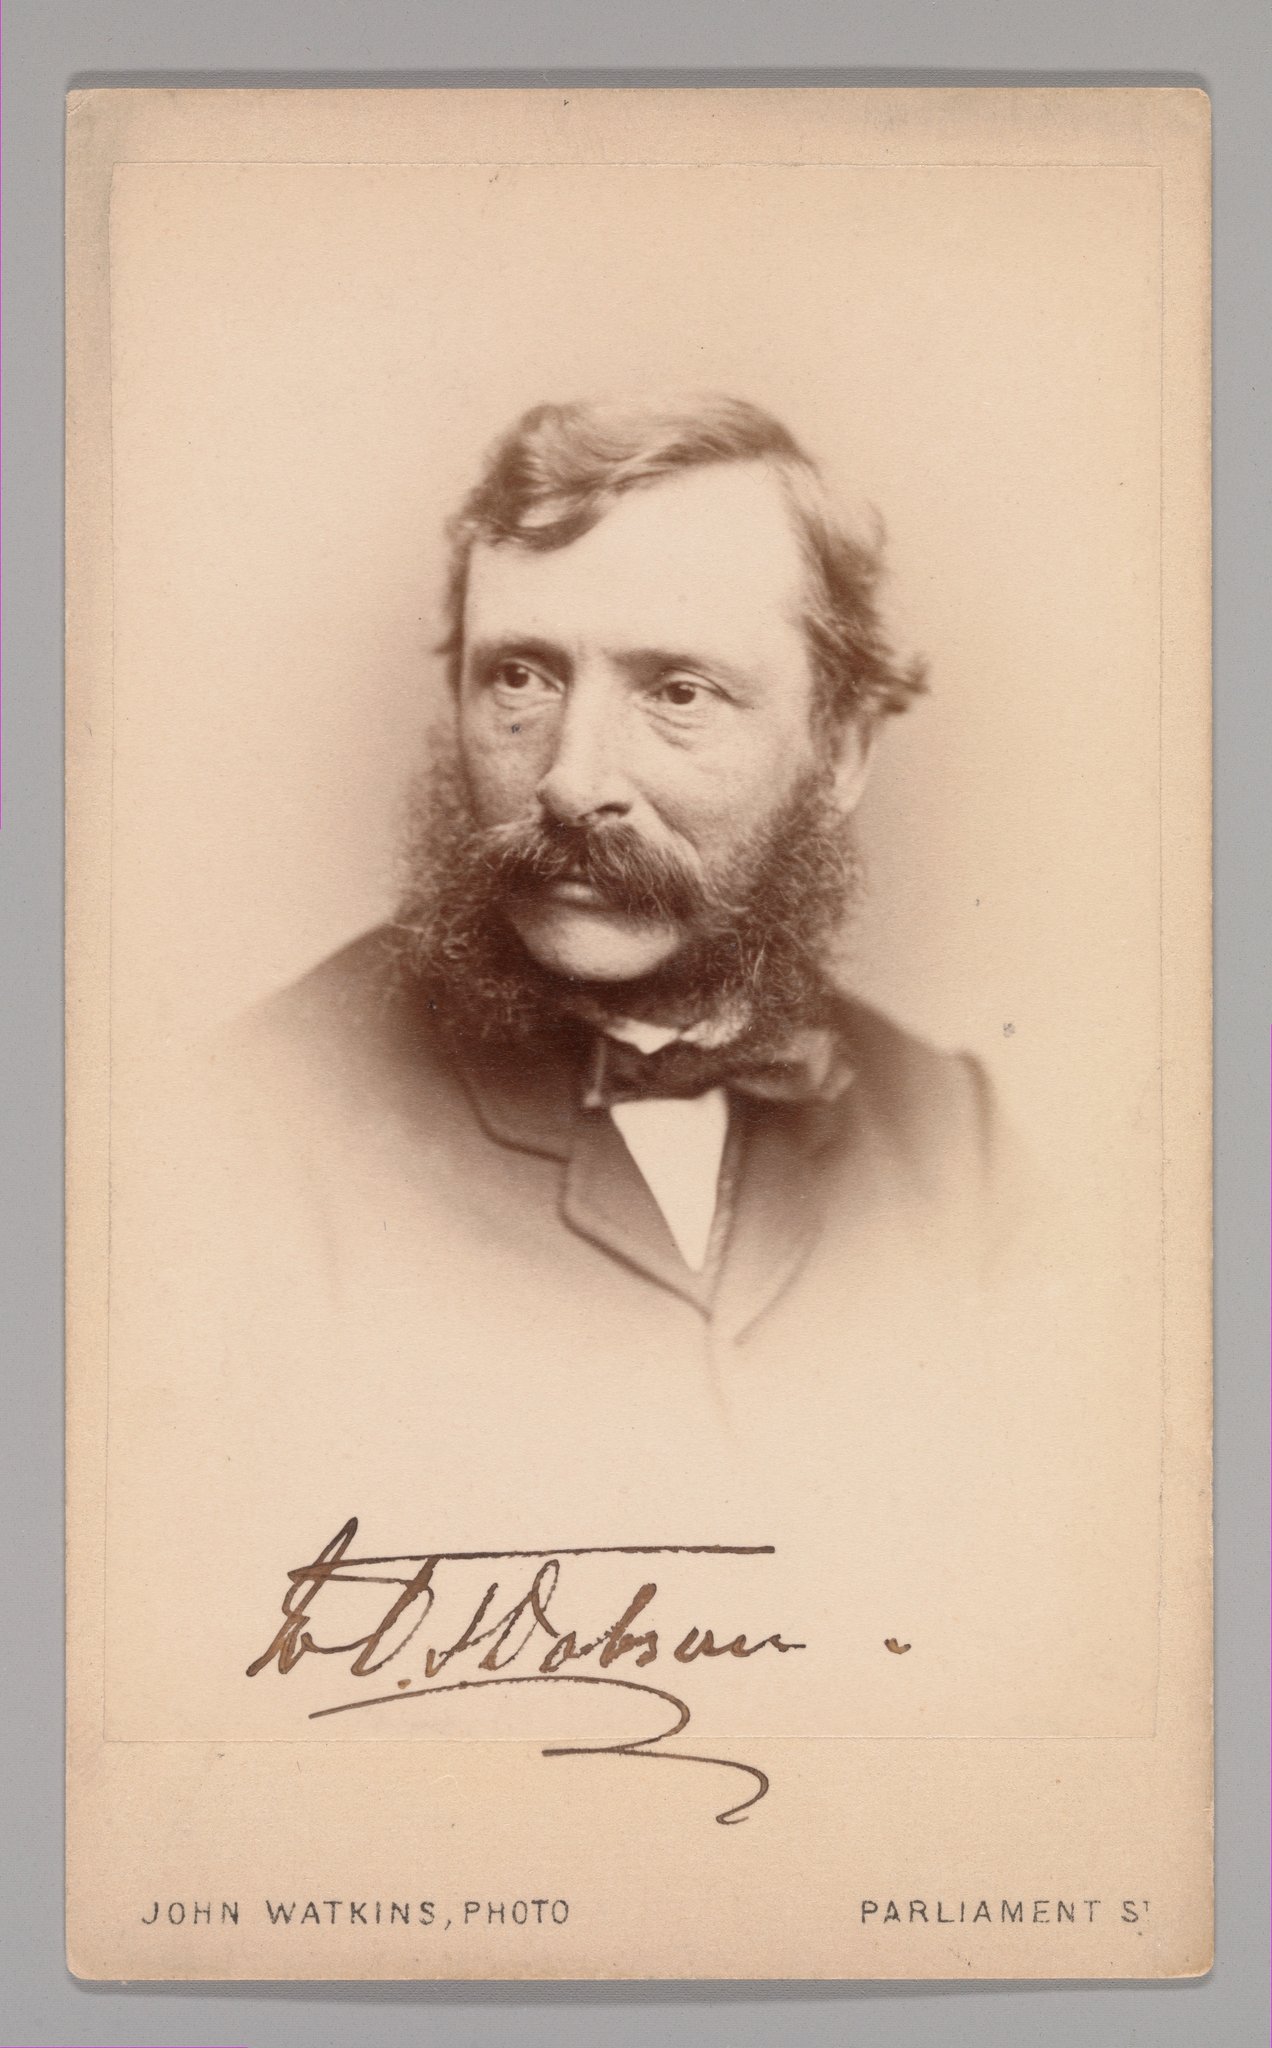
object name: carte de visite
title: [William Charles Thomas Dobson]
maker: john and charles watkins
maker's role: photography studio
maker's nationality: british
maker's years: 1840-1875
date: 1860-1869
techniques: albumen silver print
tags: men,portraits